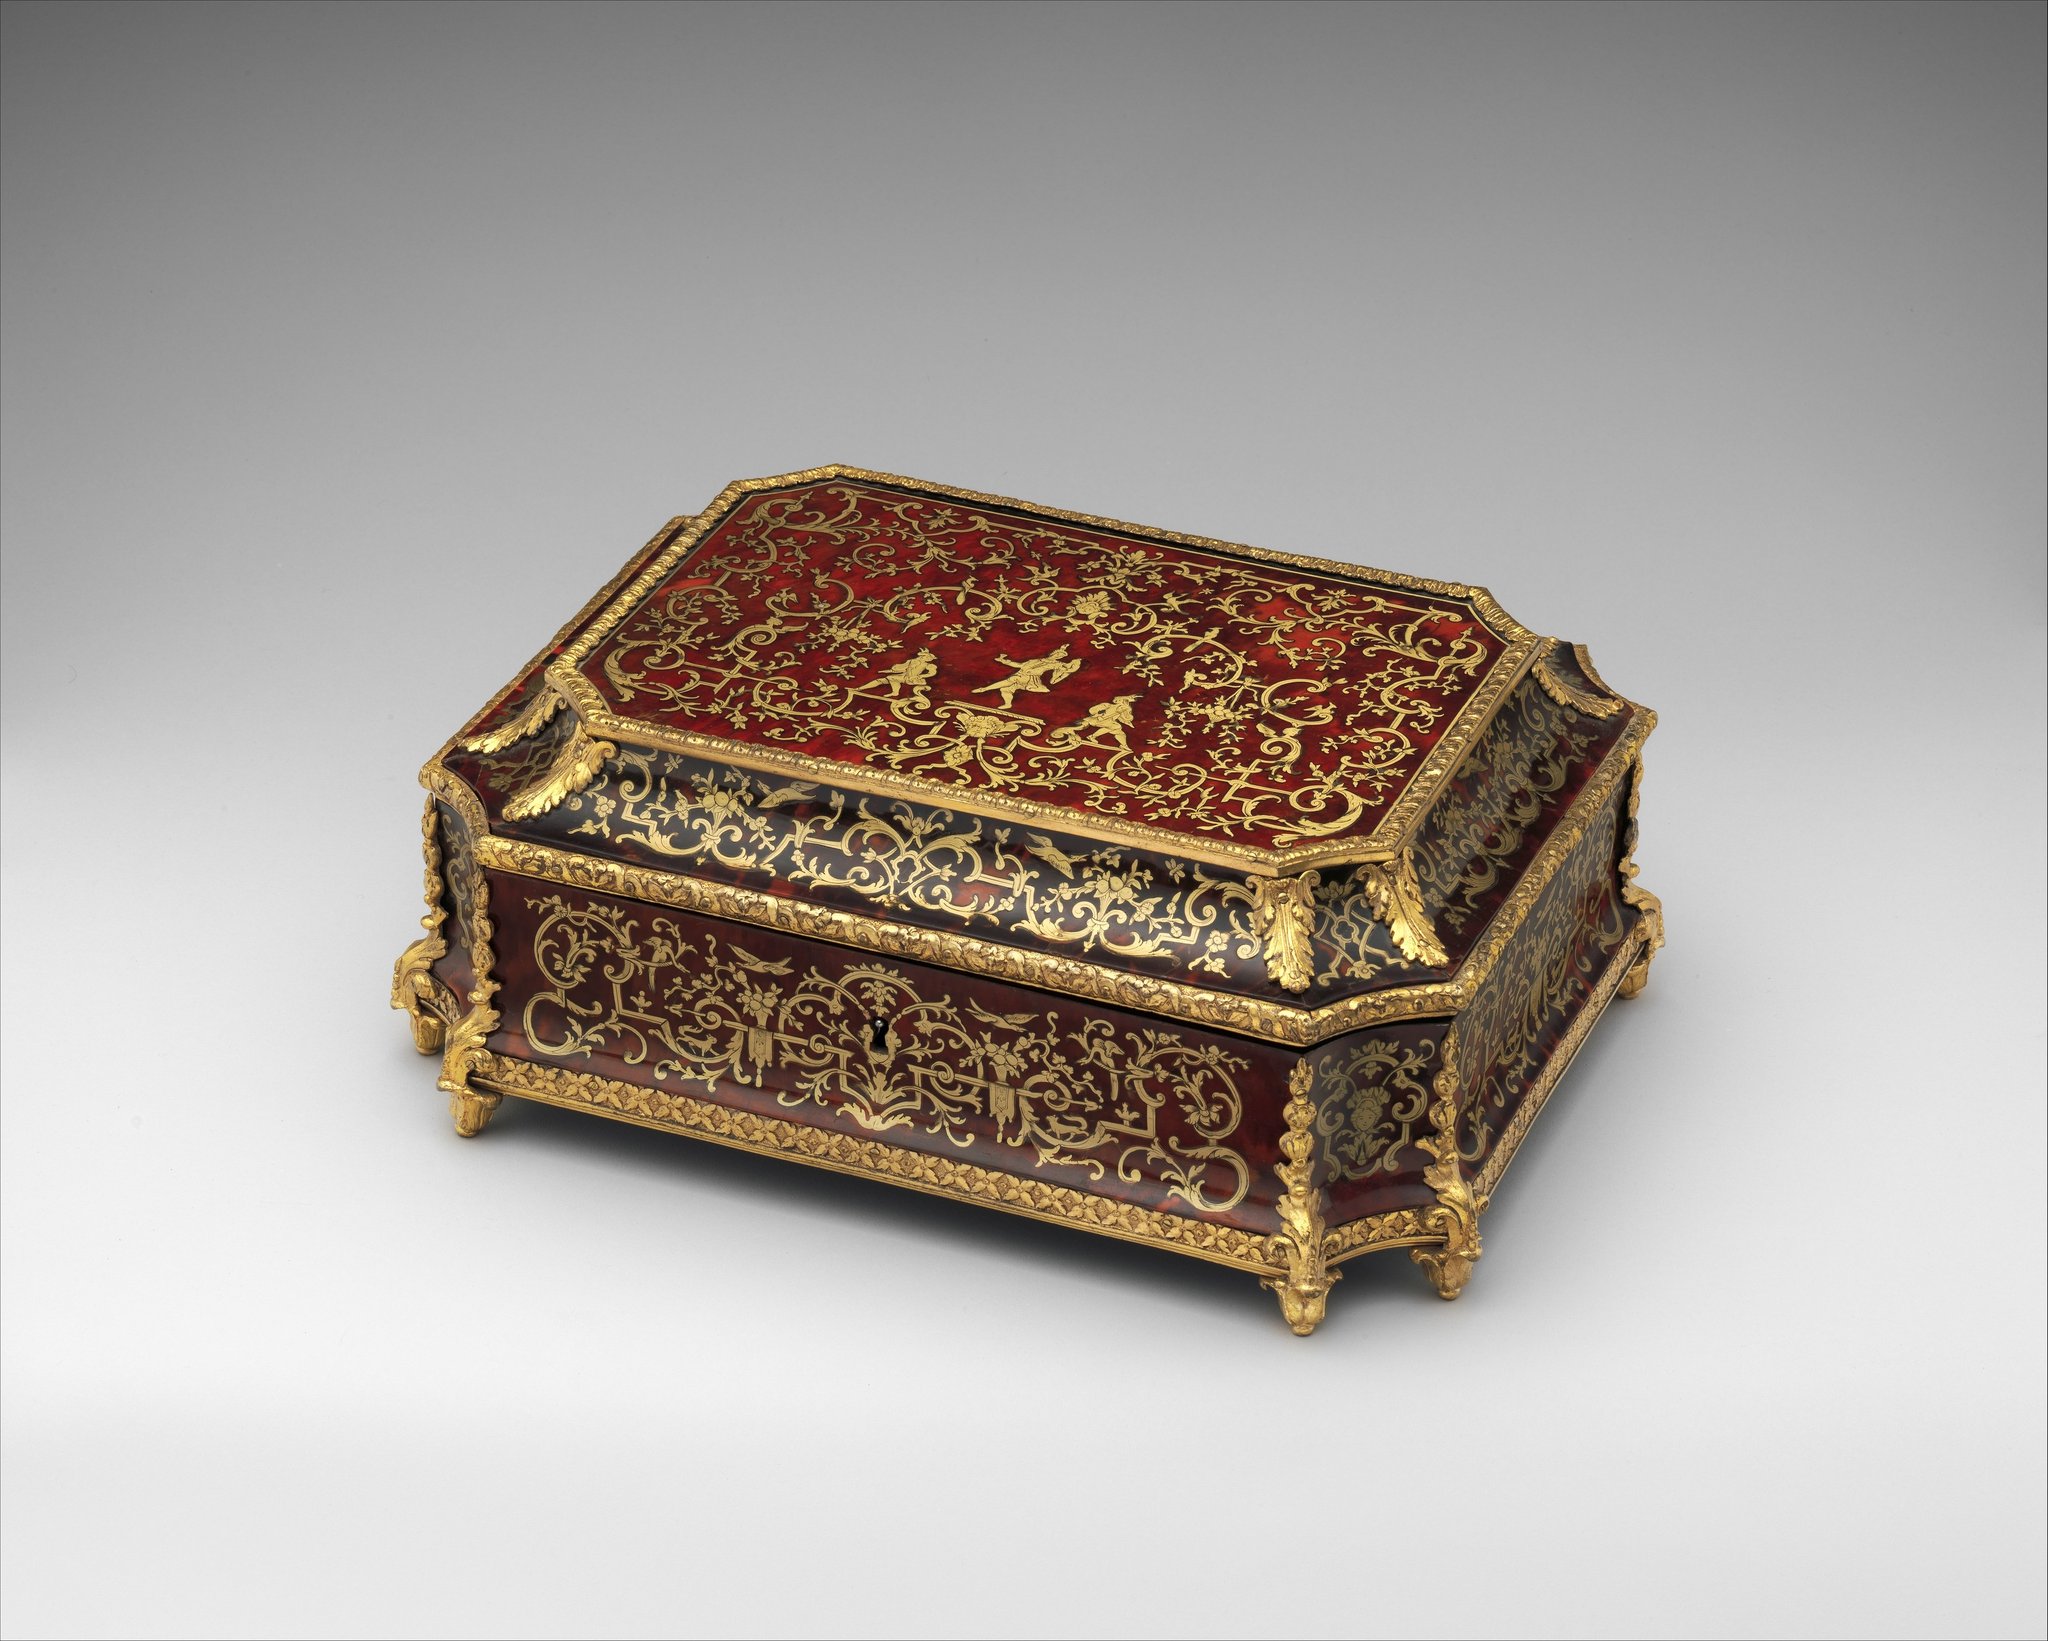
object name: toilet casket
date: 1700-1715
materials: brass, gilt bronze, wood, steel, shell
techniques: veneering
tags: faces,women